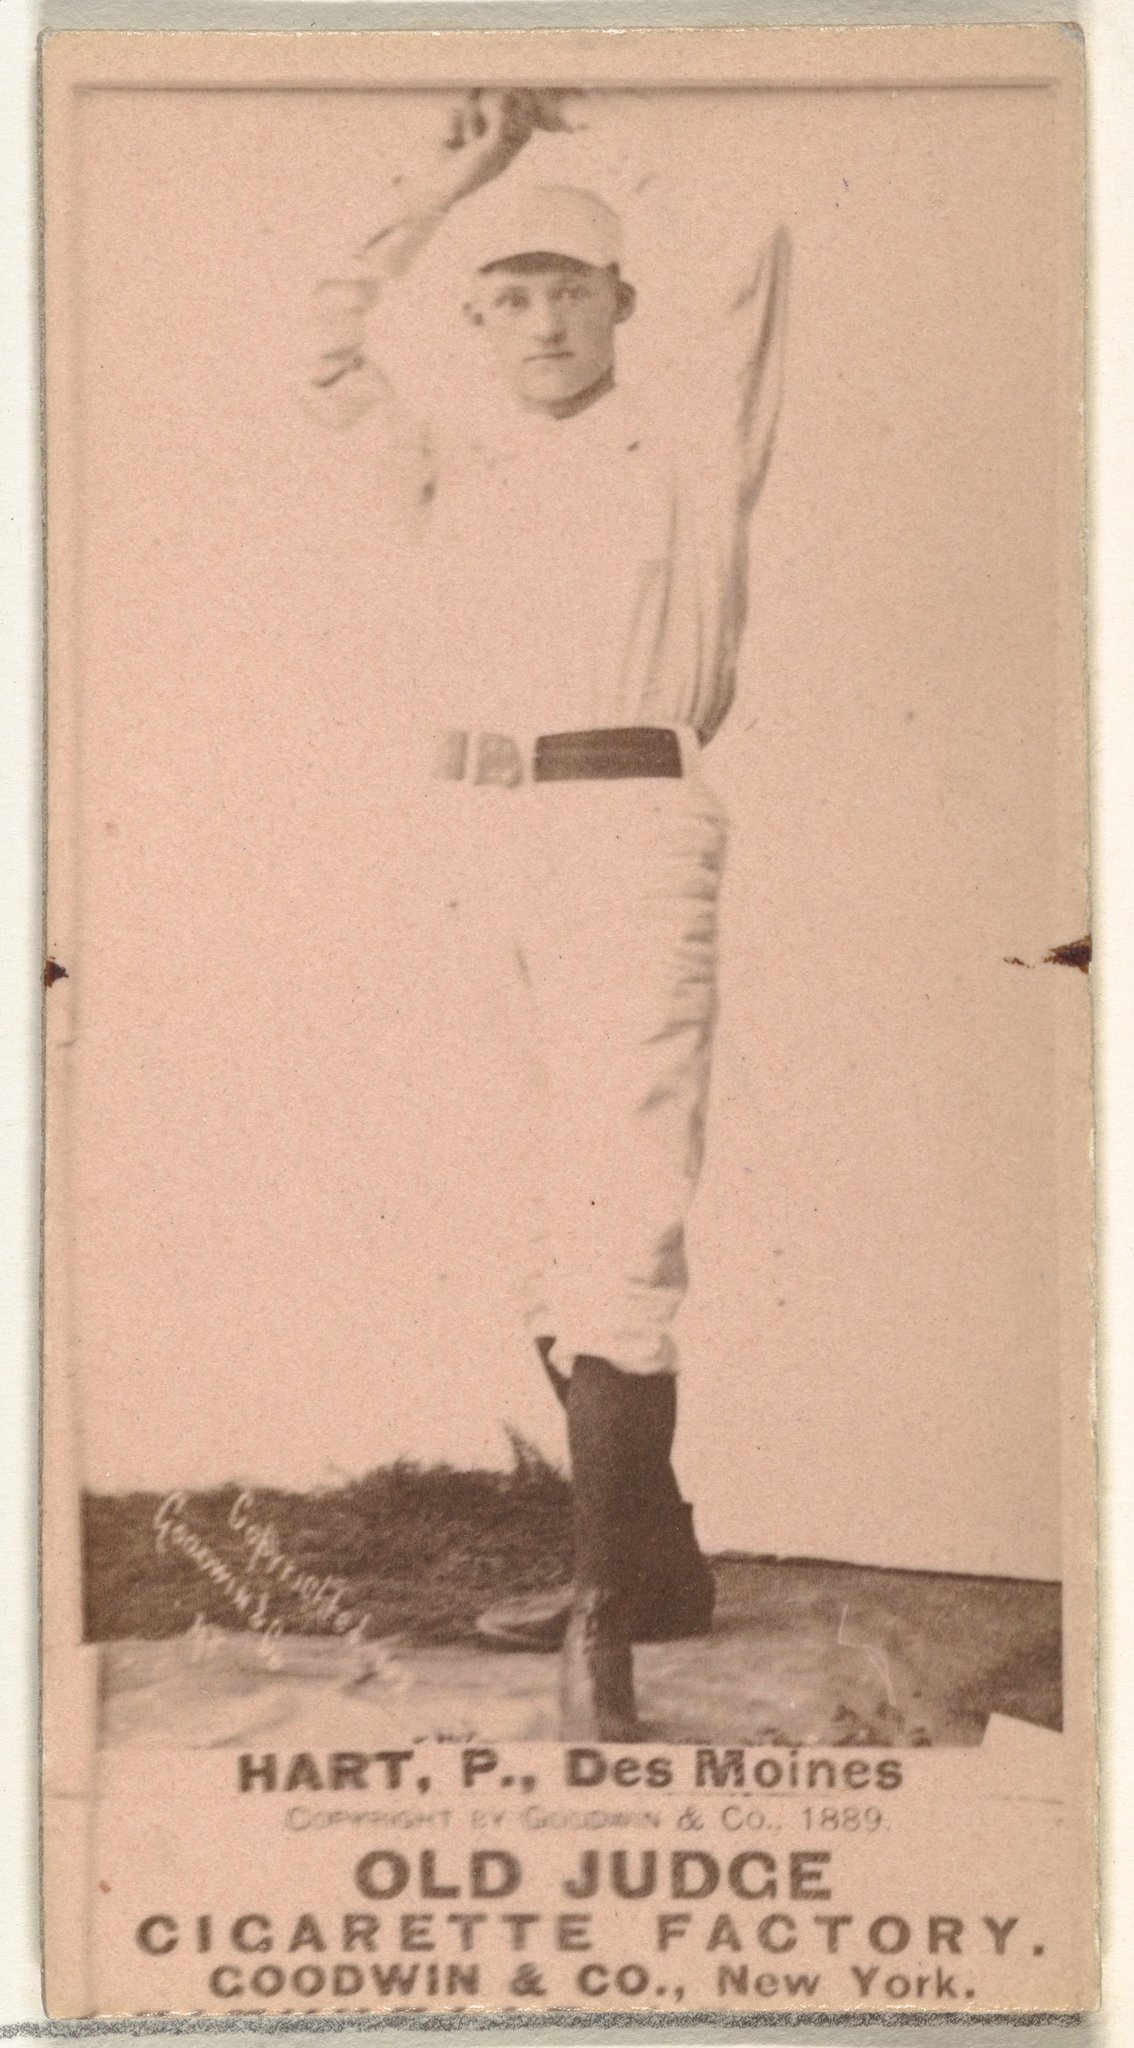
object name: baseball card, photograph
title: William Franklin "Bill" Hart, Pitcher, Des Moines Prohibitionists, from the Old Judge series (N172) for Old Judge Cigarettes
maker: goodwin & company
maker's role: publisher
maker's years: 1850-1950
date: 1889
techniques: albumen silver print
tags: men,portraits,baseball,athletes